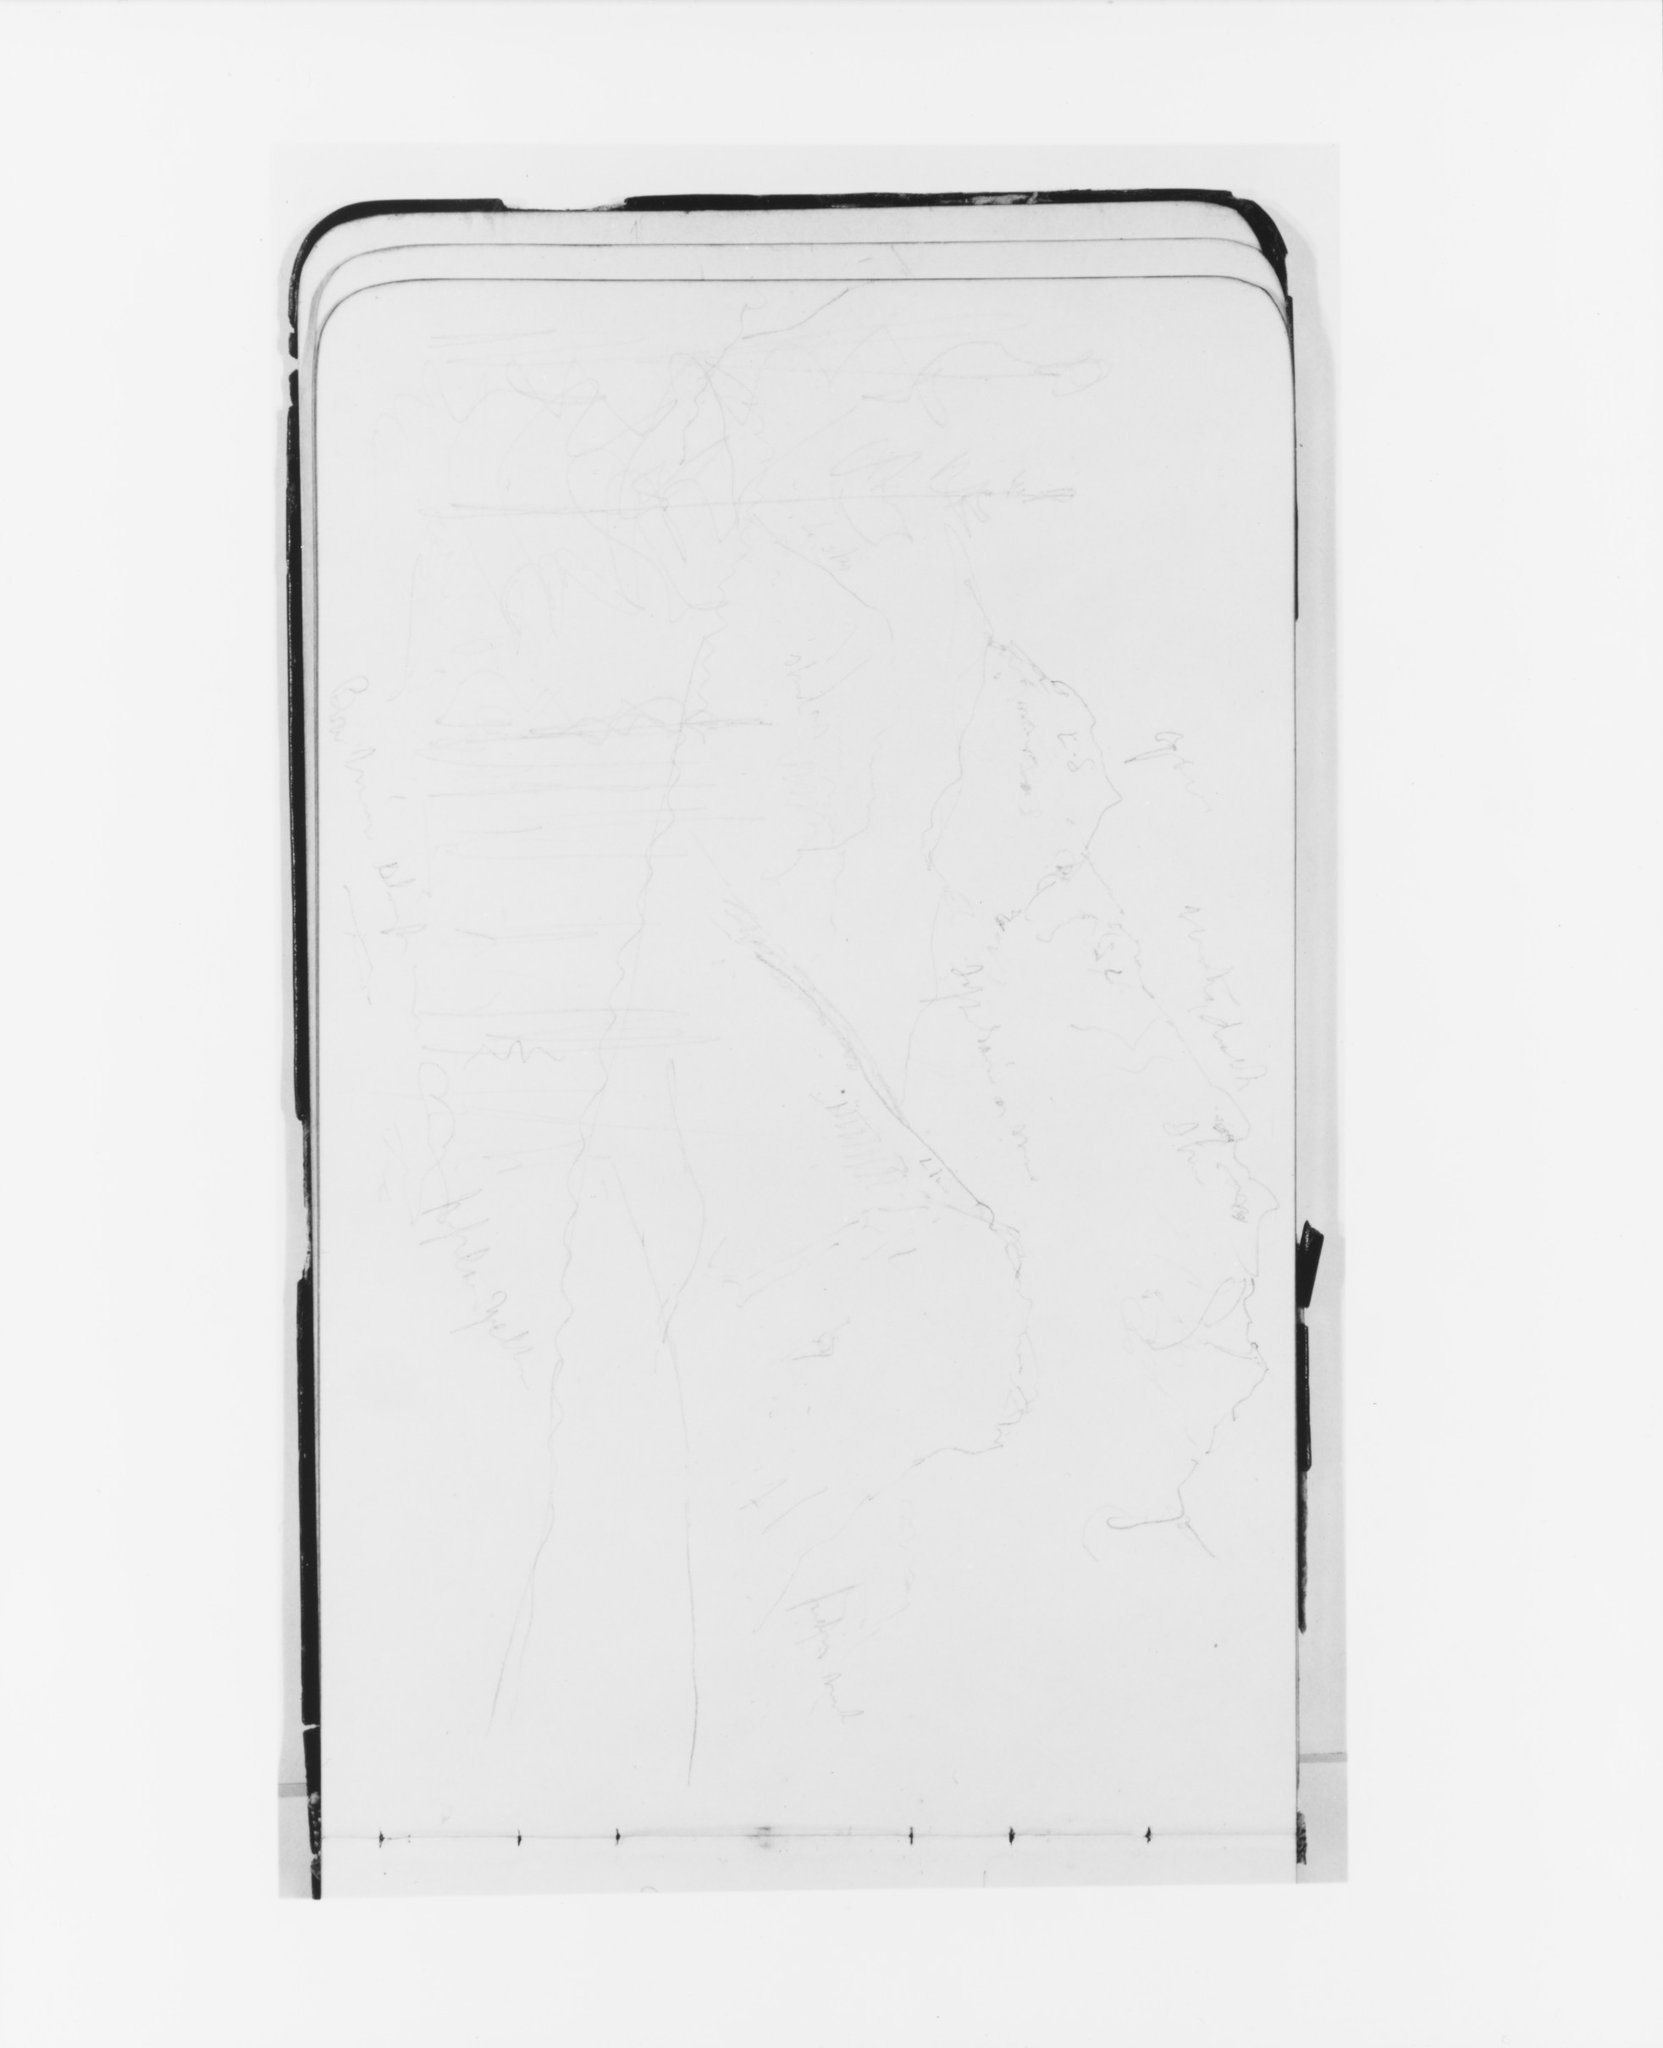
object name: drawing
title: Sketch of Bow River and Canadian Rockies (from Sketchbook)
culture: american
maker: albert bierstadt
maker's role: artist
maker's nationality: american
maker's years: 1830-1902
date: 1890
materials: graphite, paper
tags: landscapes